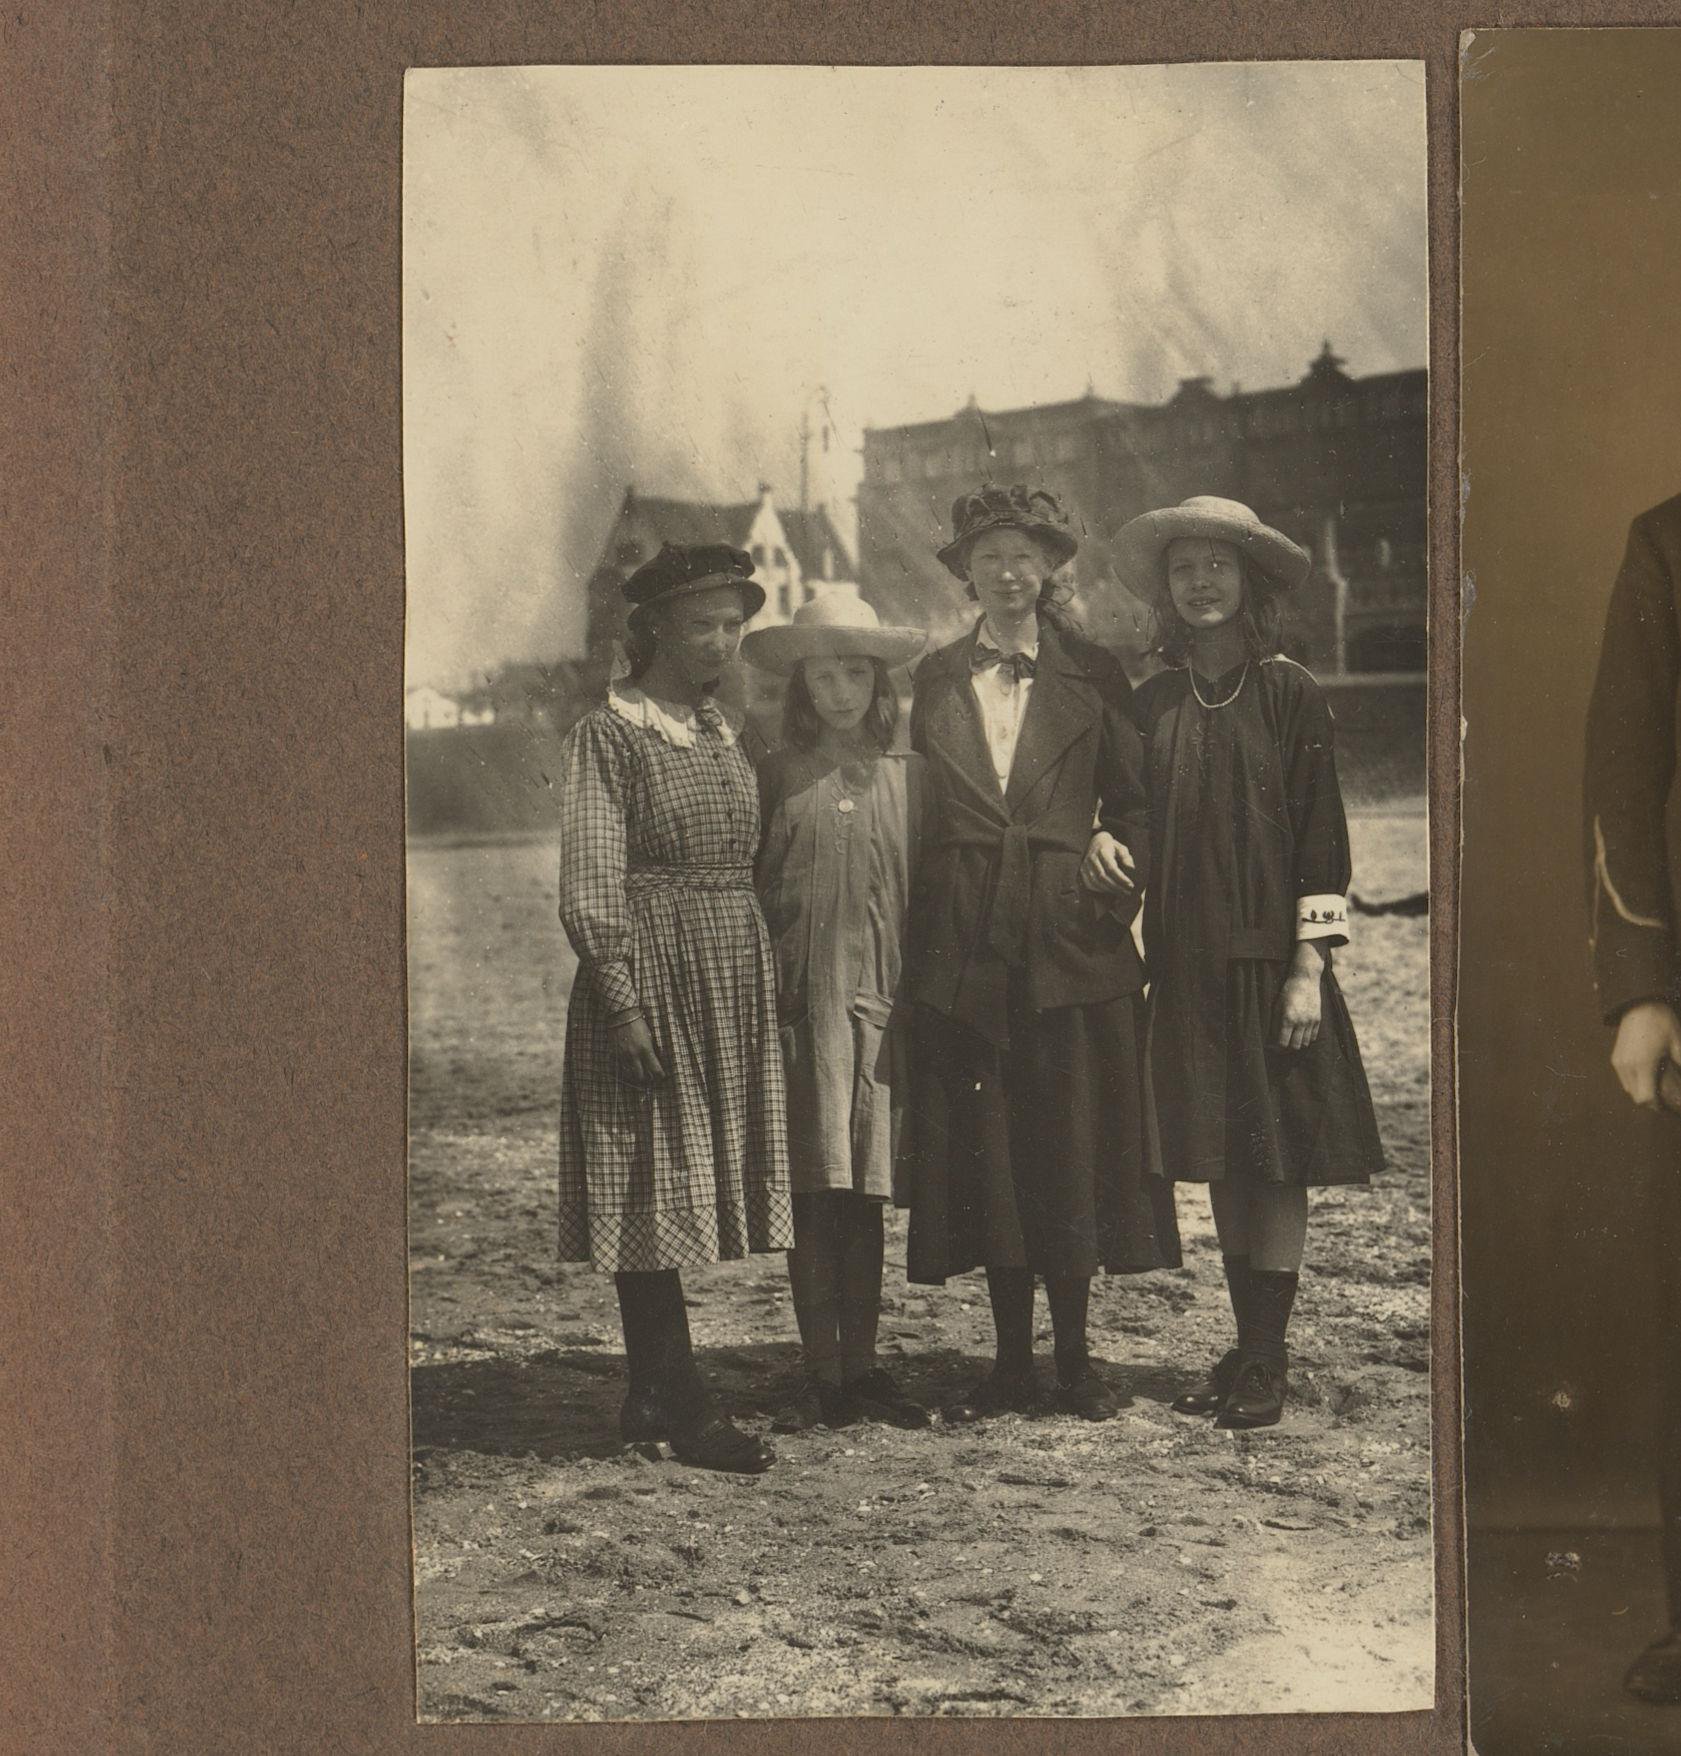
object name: photograph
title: Vier staande vrouwen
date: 1870-1920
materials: photographic support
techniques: photography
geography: amsterdam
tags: netherlands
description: Foto op bruin albumblad 39 van familiealbum van Alphons Diepenbrock.